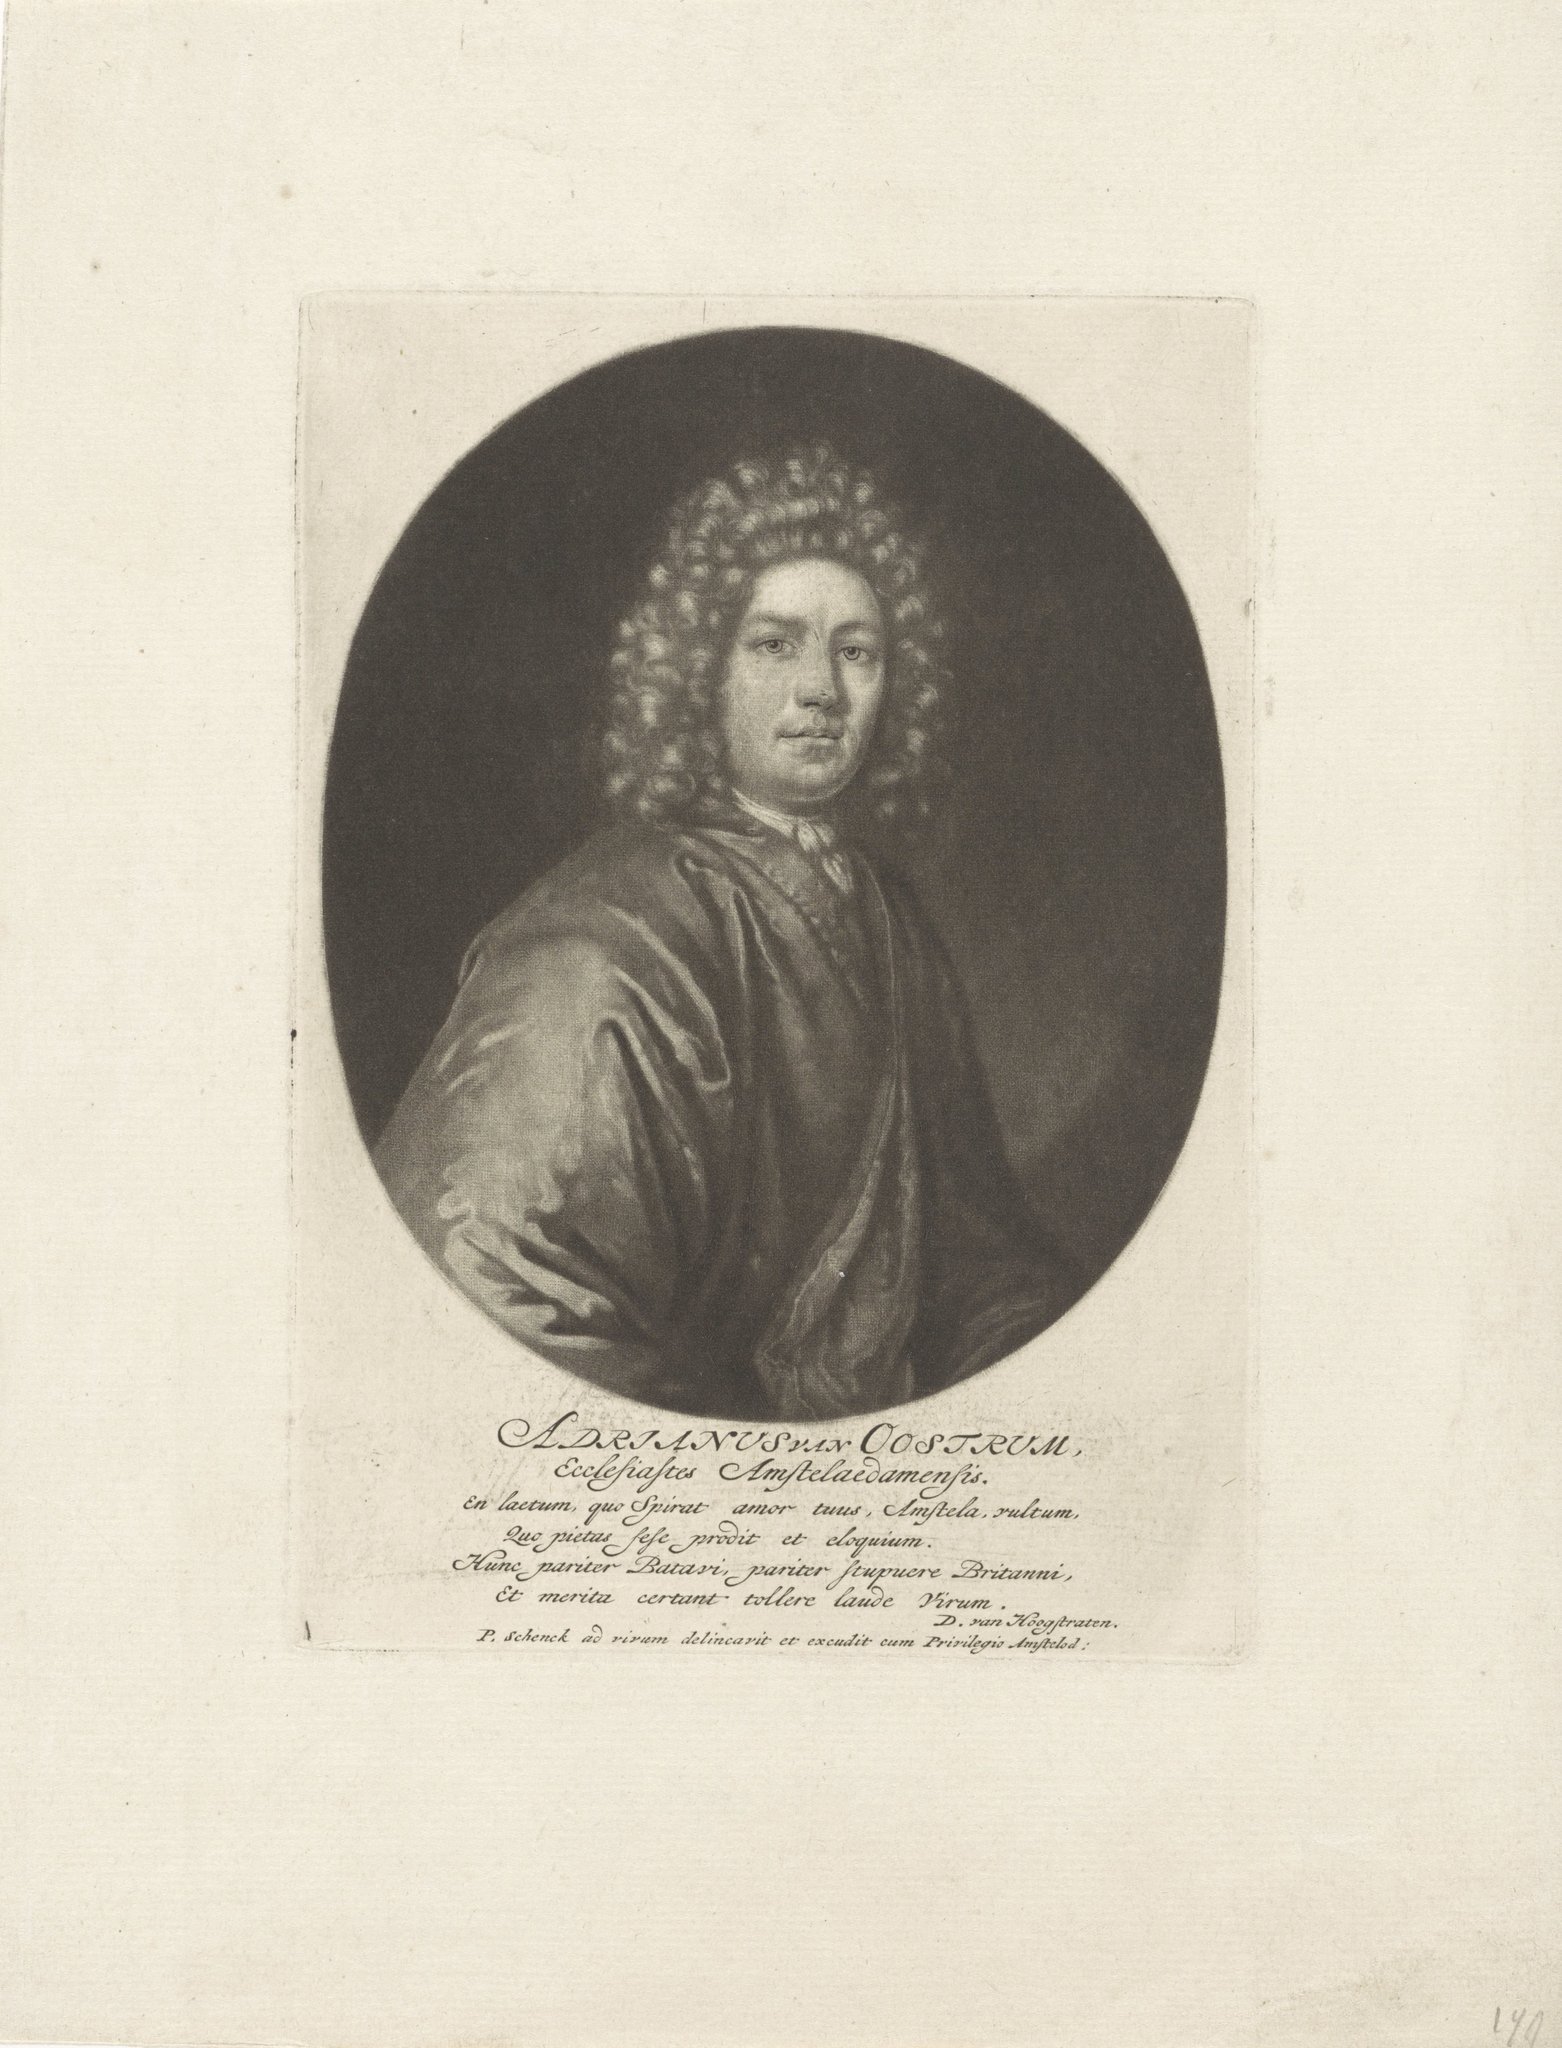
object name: print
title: Portret van de predikant Adriaan van Oostrum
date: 1670-1713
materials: paper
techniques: engraving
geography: amsterdam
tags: wig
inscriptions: collector's mark: Lugt 2165